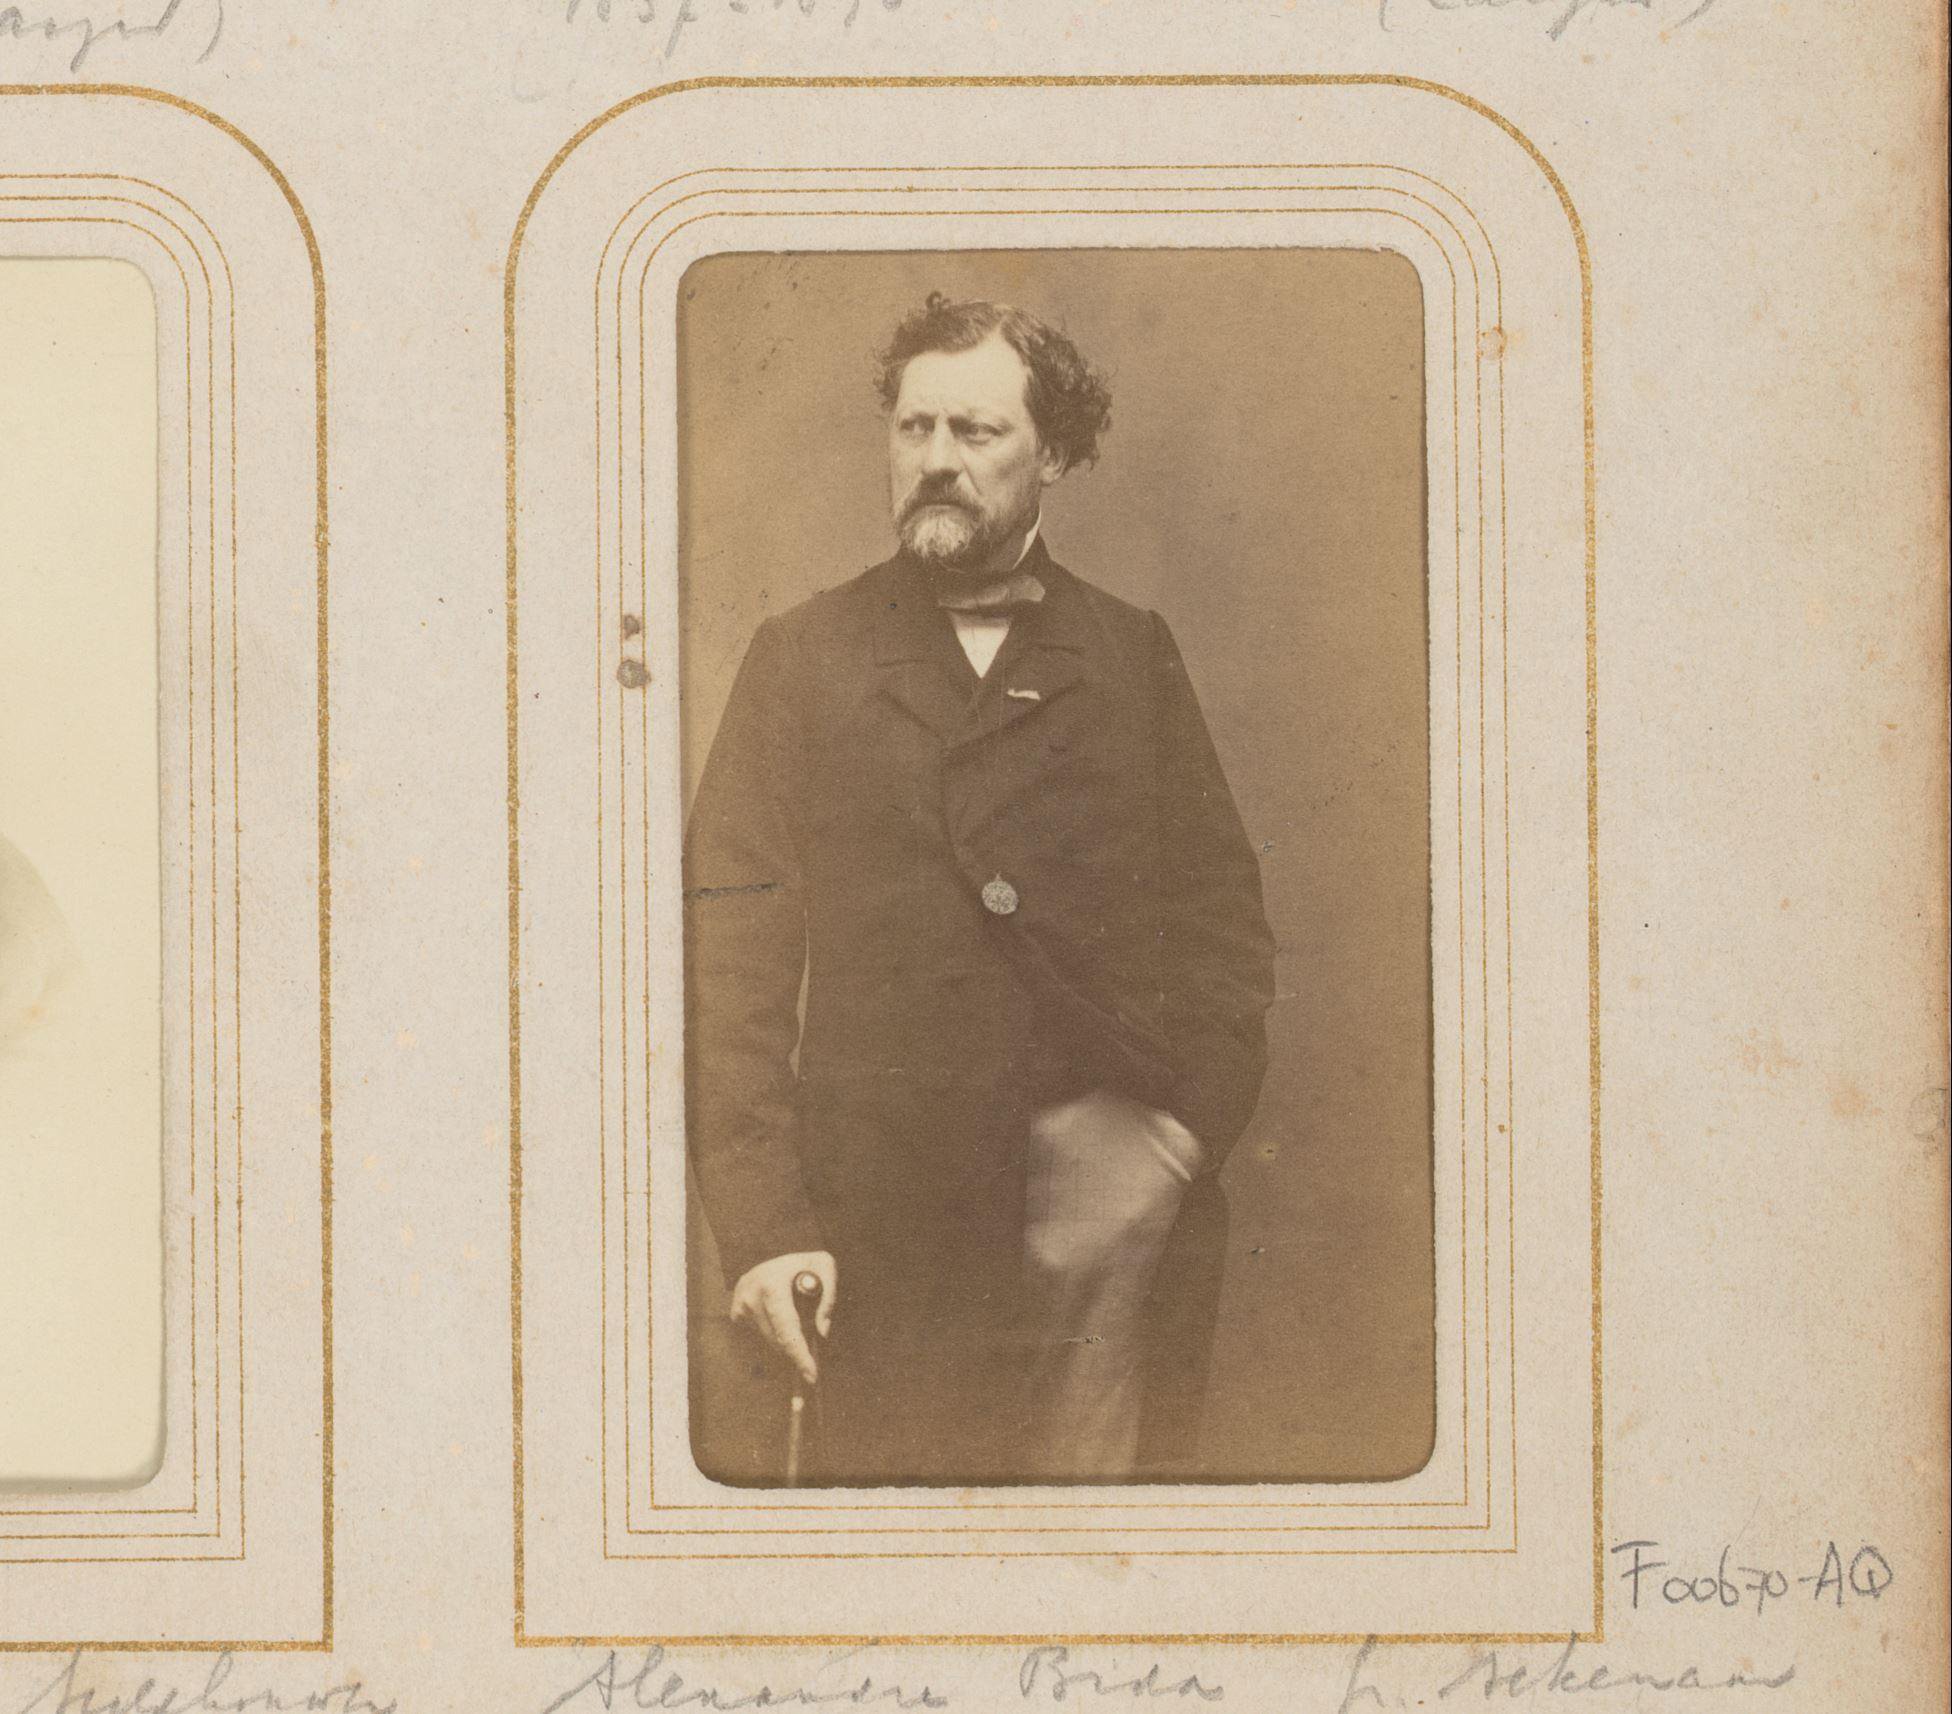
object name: carte de visite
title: Portret van Alexandre Bida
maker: étienne carjat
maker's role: draughtsman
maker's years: 1828-1906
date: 1861-1867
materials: cardboard, photographic support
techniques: albumen print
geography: paris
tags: painter, draughtsman, alexandre bida, historical persons, portrait, self-portrait of painter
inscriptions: annotation: ‘Alexandre Bida fr. tekenaar/ 1813-1895 (Carjat)’, inscription: ‘Photographie/ Carjat & Cie/ 56, Rue Laffitte (...)’